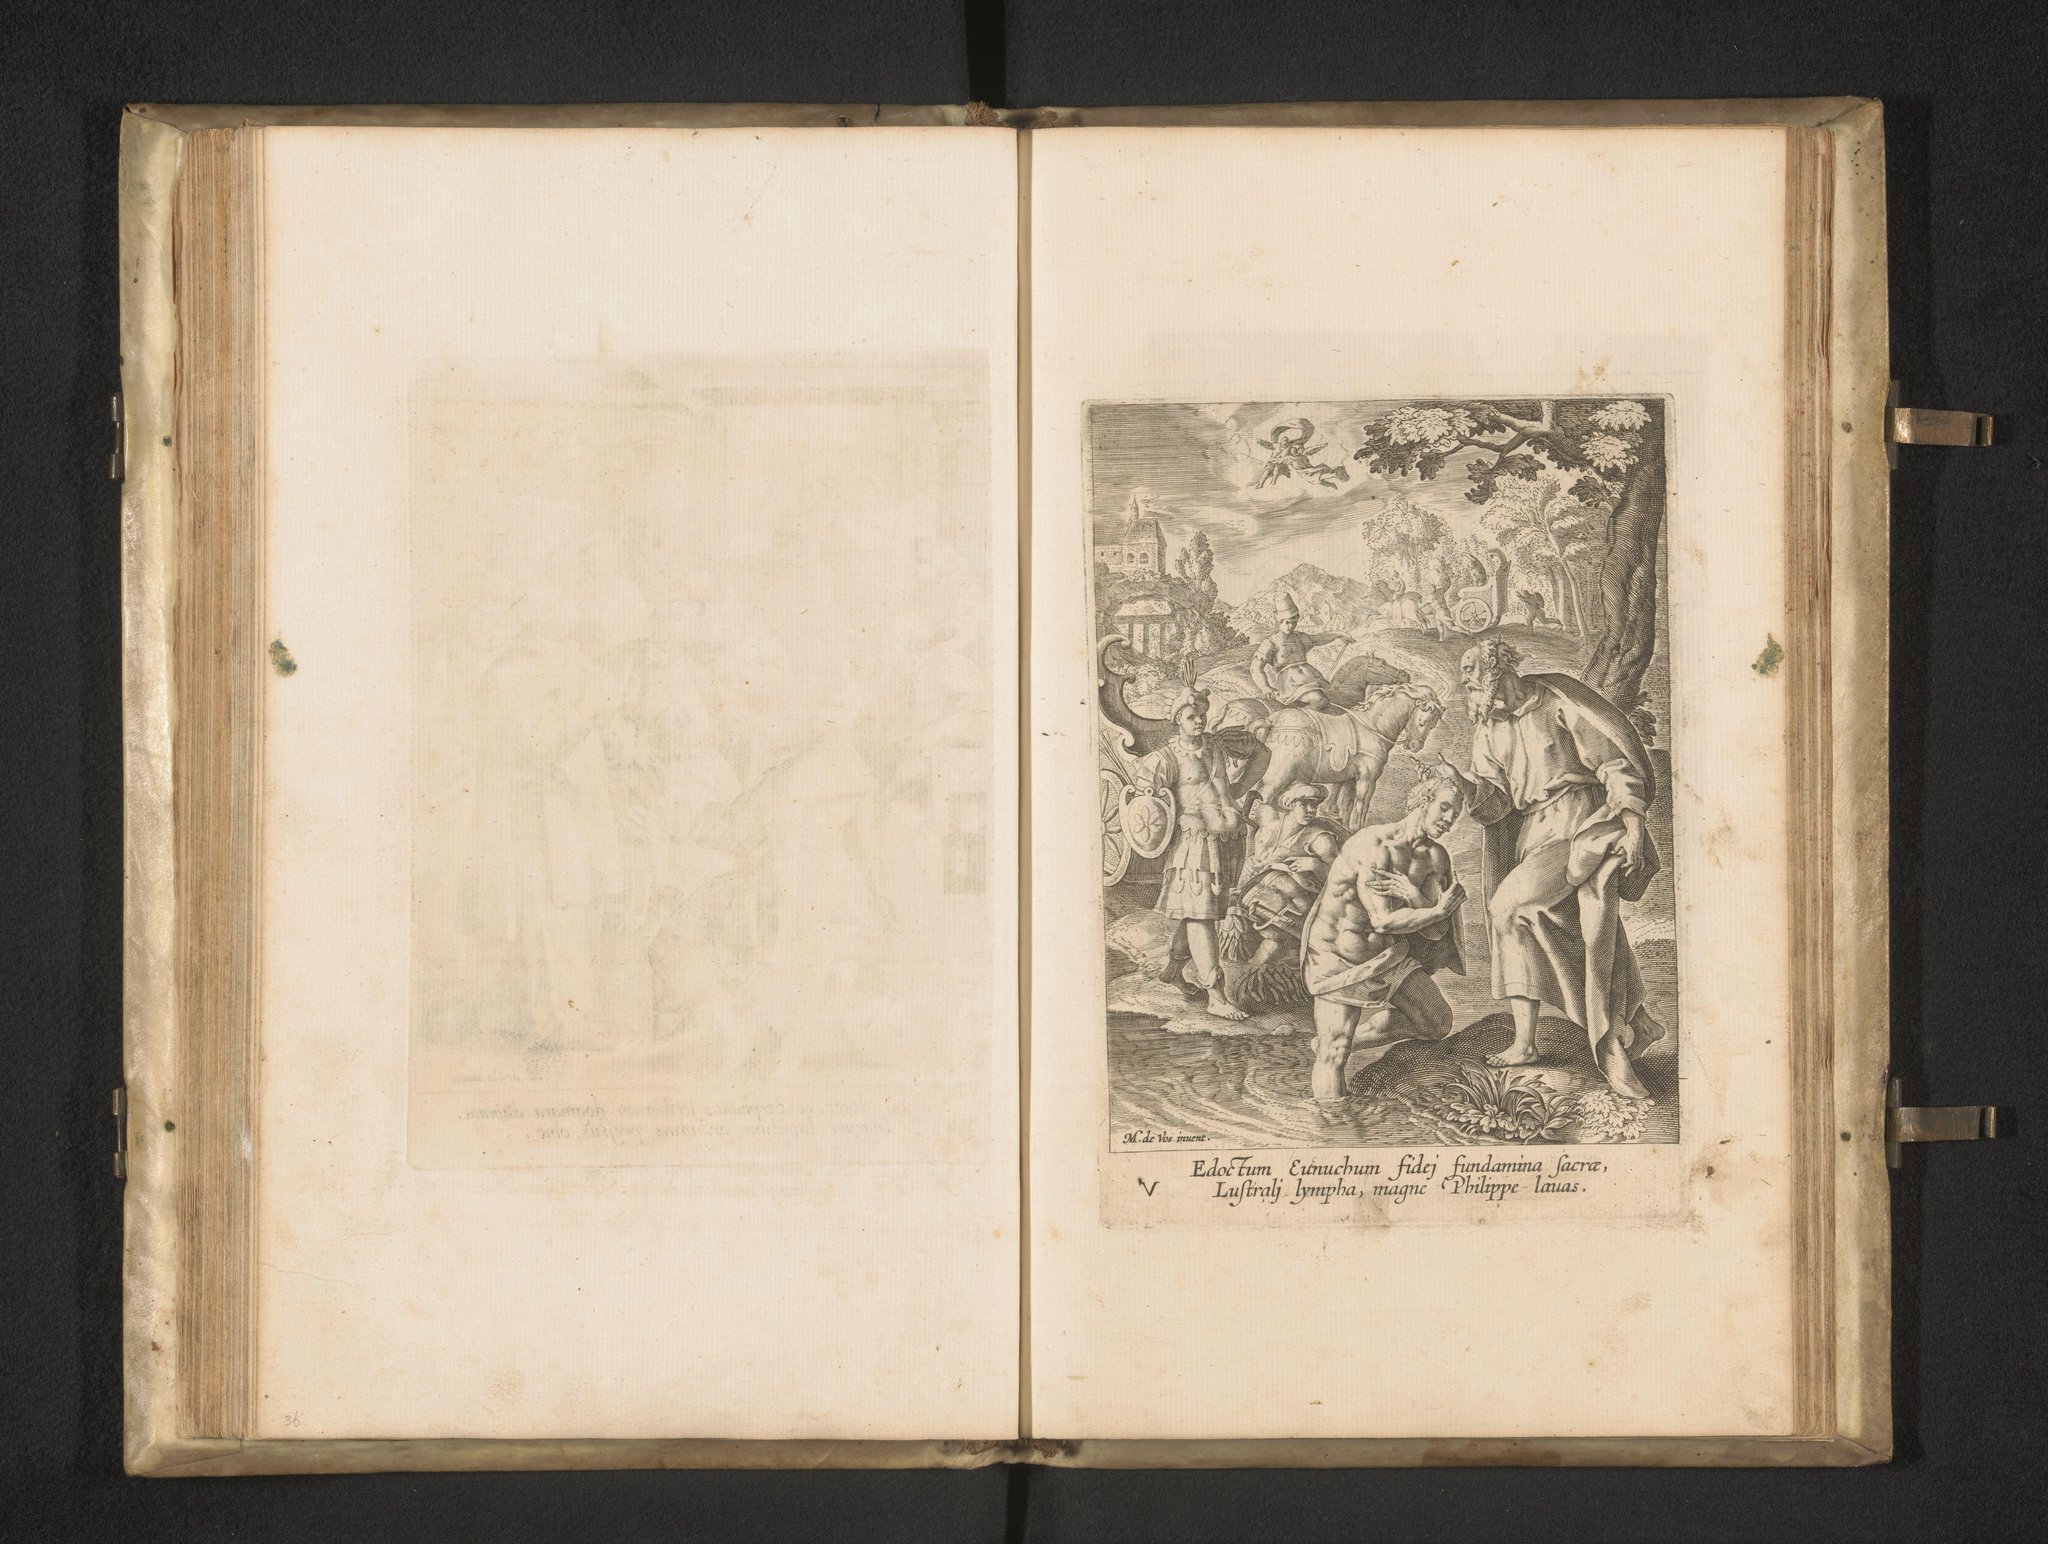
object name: print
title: Doop van de kamerling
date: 1580-1585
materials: paper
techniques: engraving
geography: antwerp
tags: philip baptizes the eunuch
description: Filippus doopt de kamerling uit Ethiopië. Achter de kamerling wachten drie figuren bij zijn rijtuig. Linksonder genummerd: V. Onderaan in de marge een tweeregelig onderschrift in het Latijn. Onderdeel van een serie van twaalf voorstellingen van de Handelingen van de apostelen. Onderdeel van een album met voornamelijk christelijke voorstellingen.